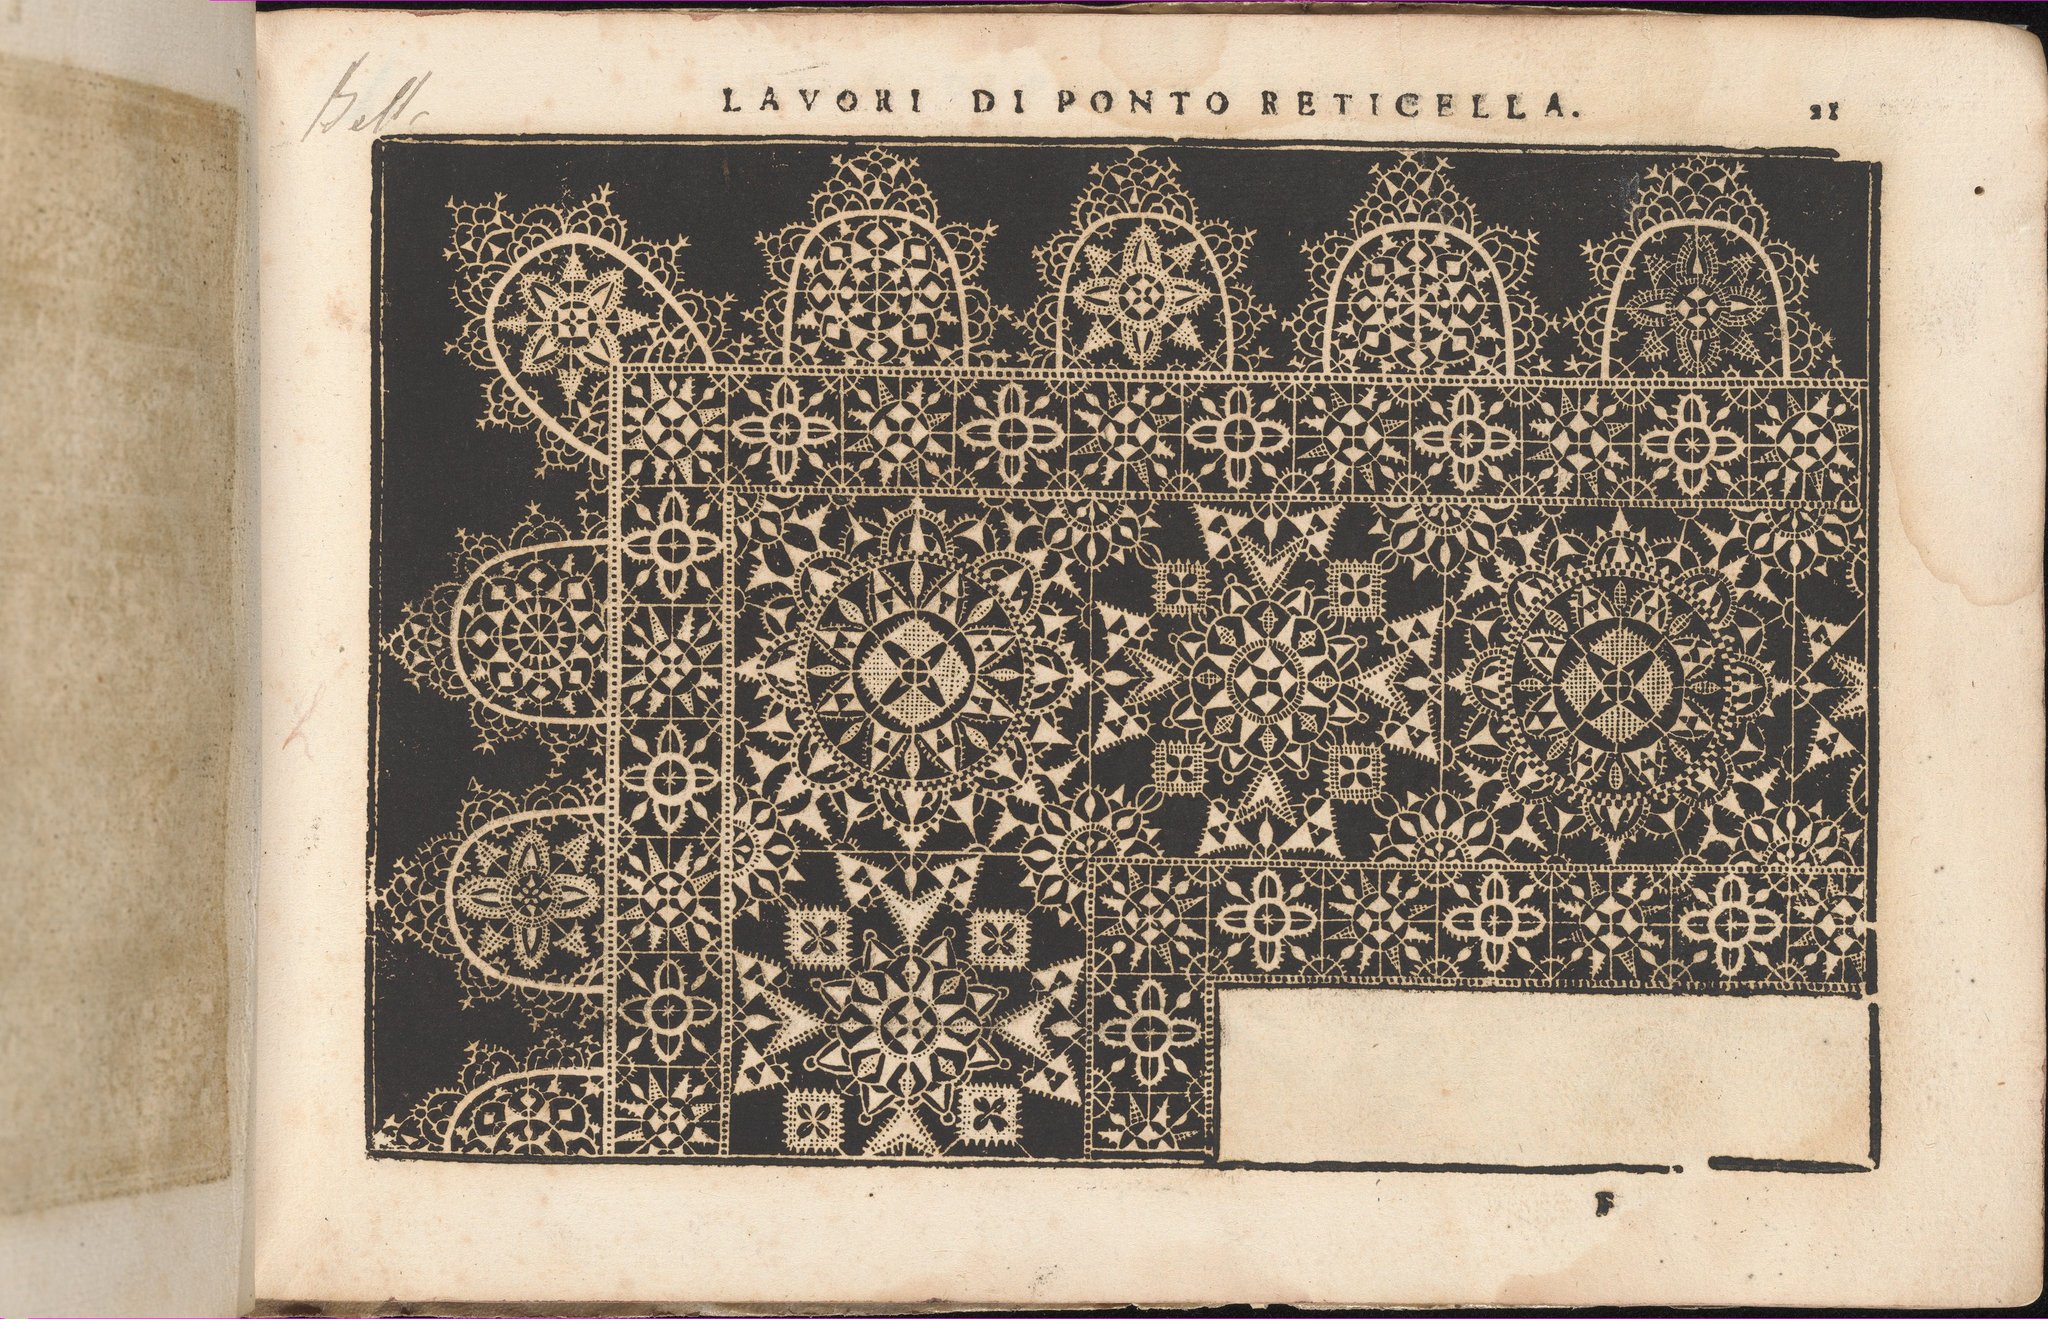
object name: book print ornament architecture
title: Teatro delle Nobili et Virtuose Donne..., page 17 (recto)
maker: isabella catanea parasole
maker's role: author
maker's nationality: italian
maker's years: 1565-1625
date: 1616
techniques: engraving, woodcut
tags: ornament